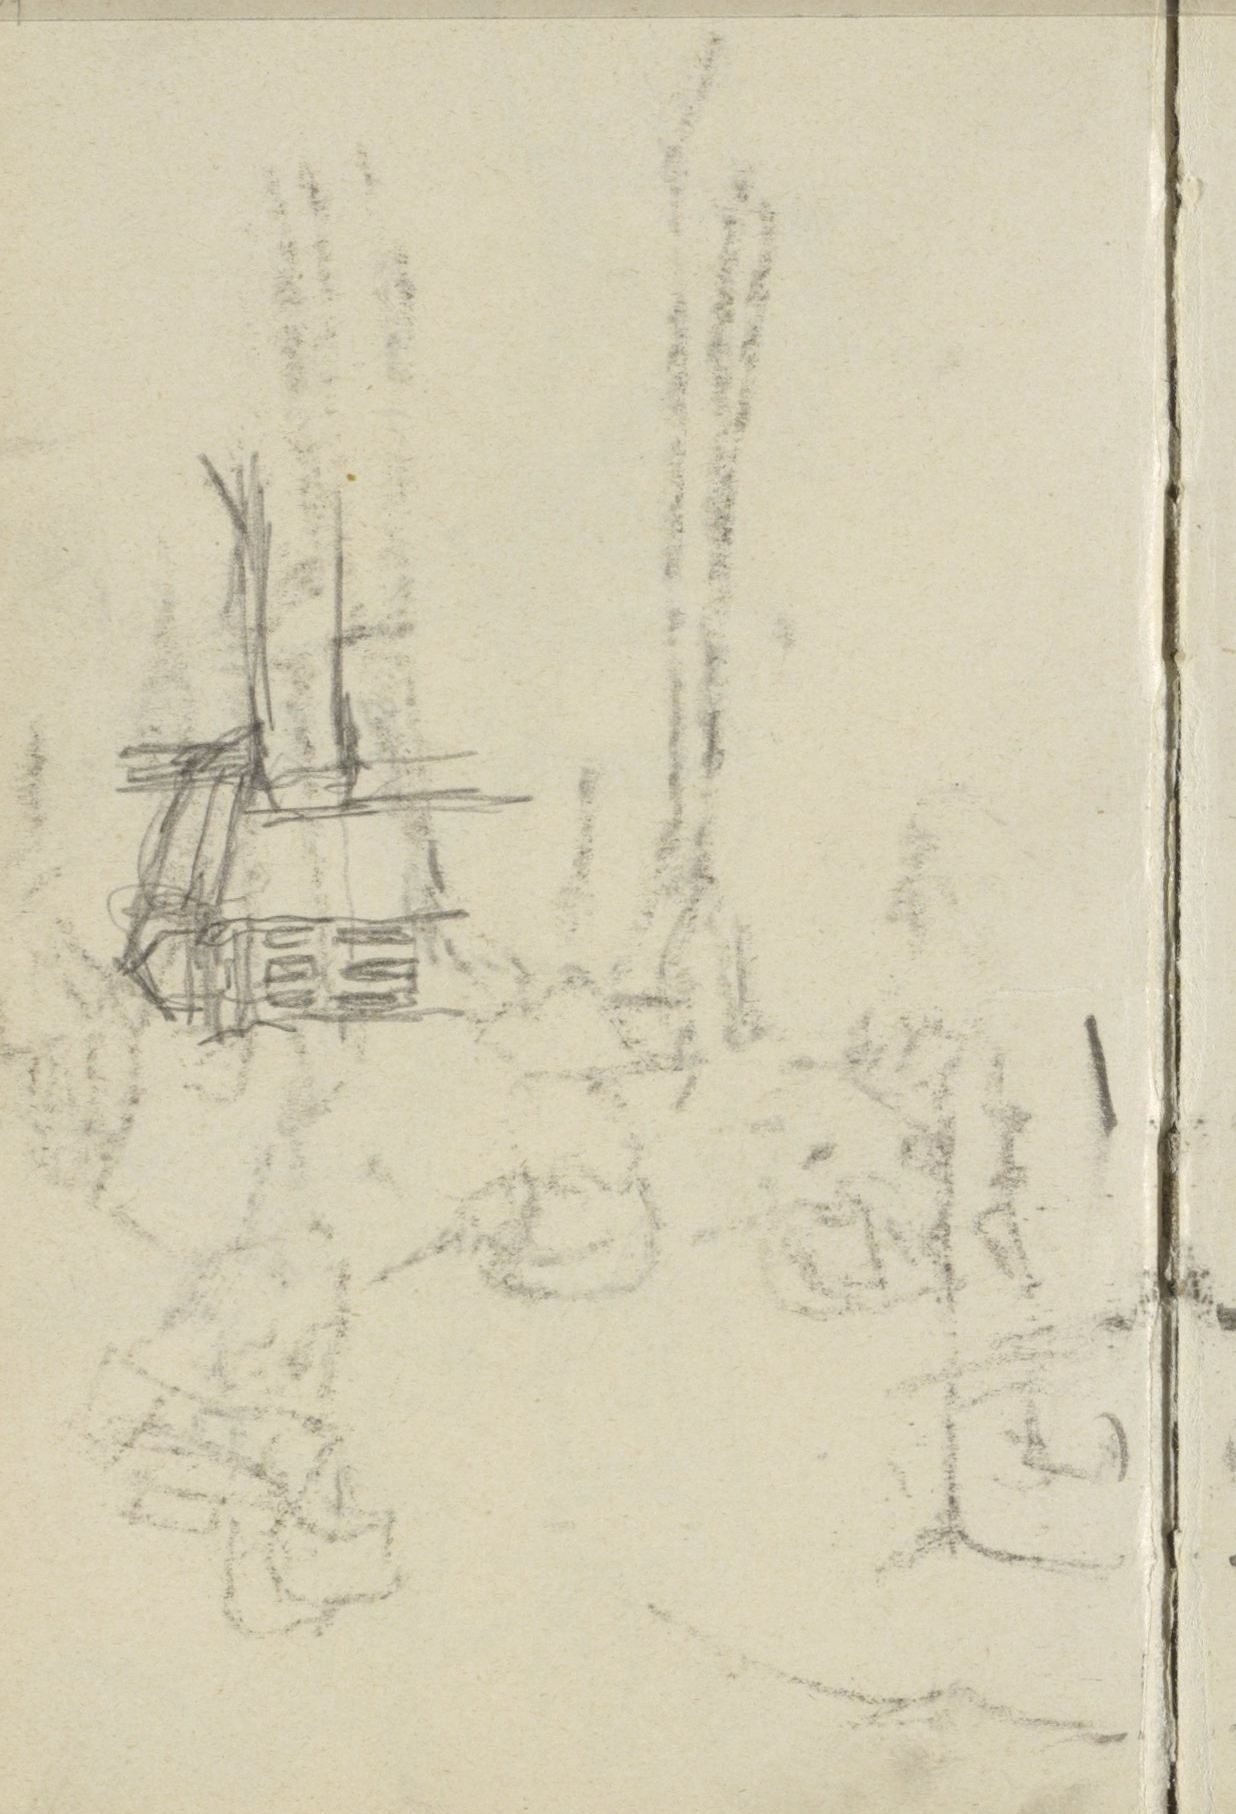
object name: sketchbook leaf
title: Gebouwen in Amsterdam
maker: george hendrik breitner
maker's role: draughtsman, painter, print maker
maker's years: 1857-1923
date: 1910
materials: chalk, paper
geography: amsterdam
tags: architecture, civic architecture; edifices; dwellings, amsterdam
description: Pagina 69 uit een schetsboek met 45 bladen.